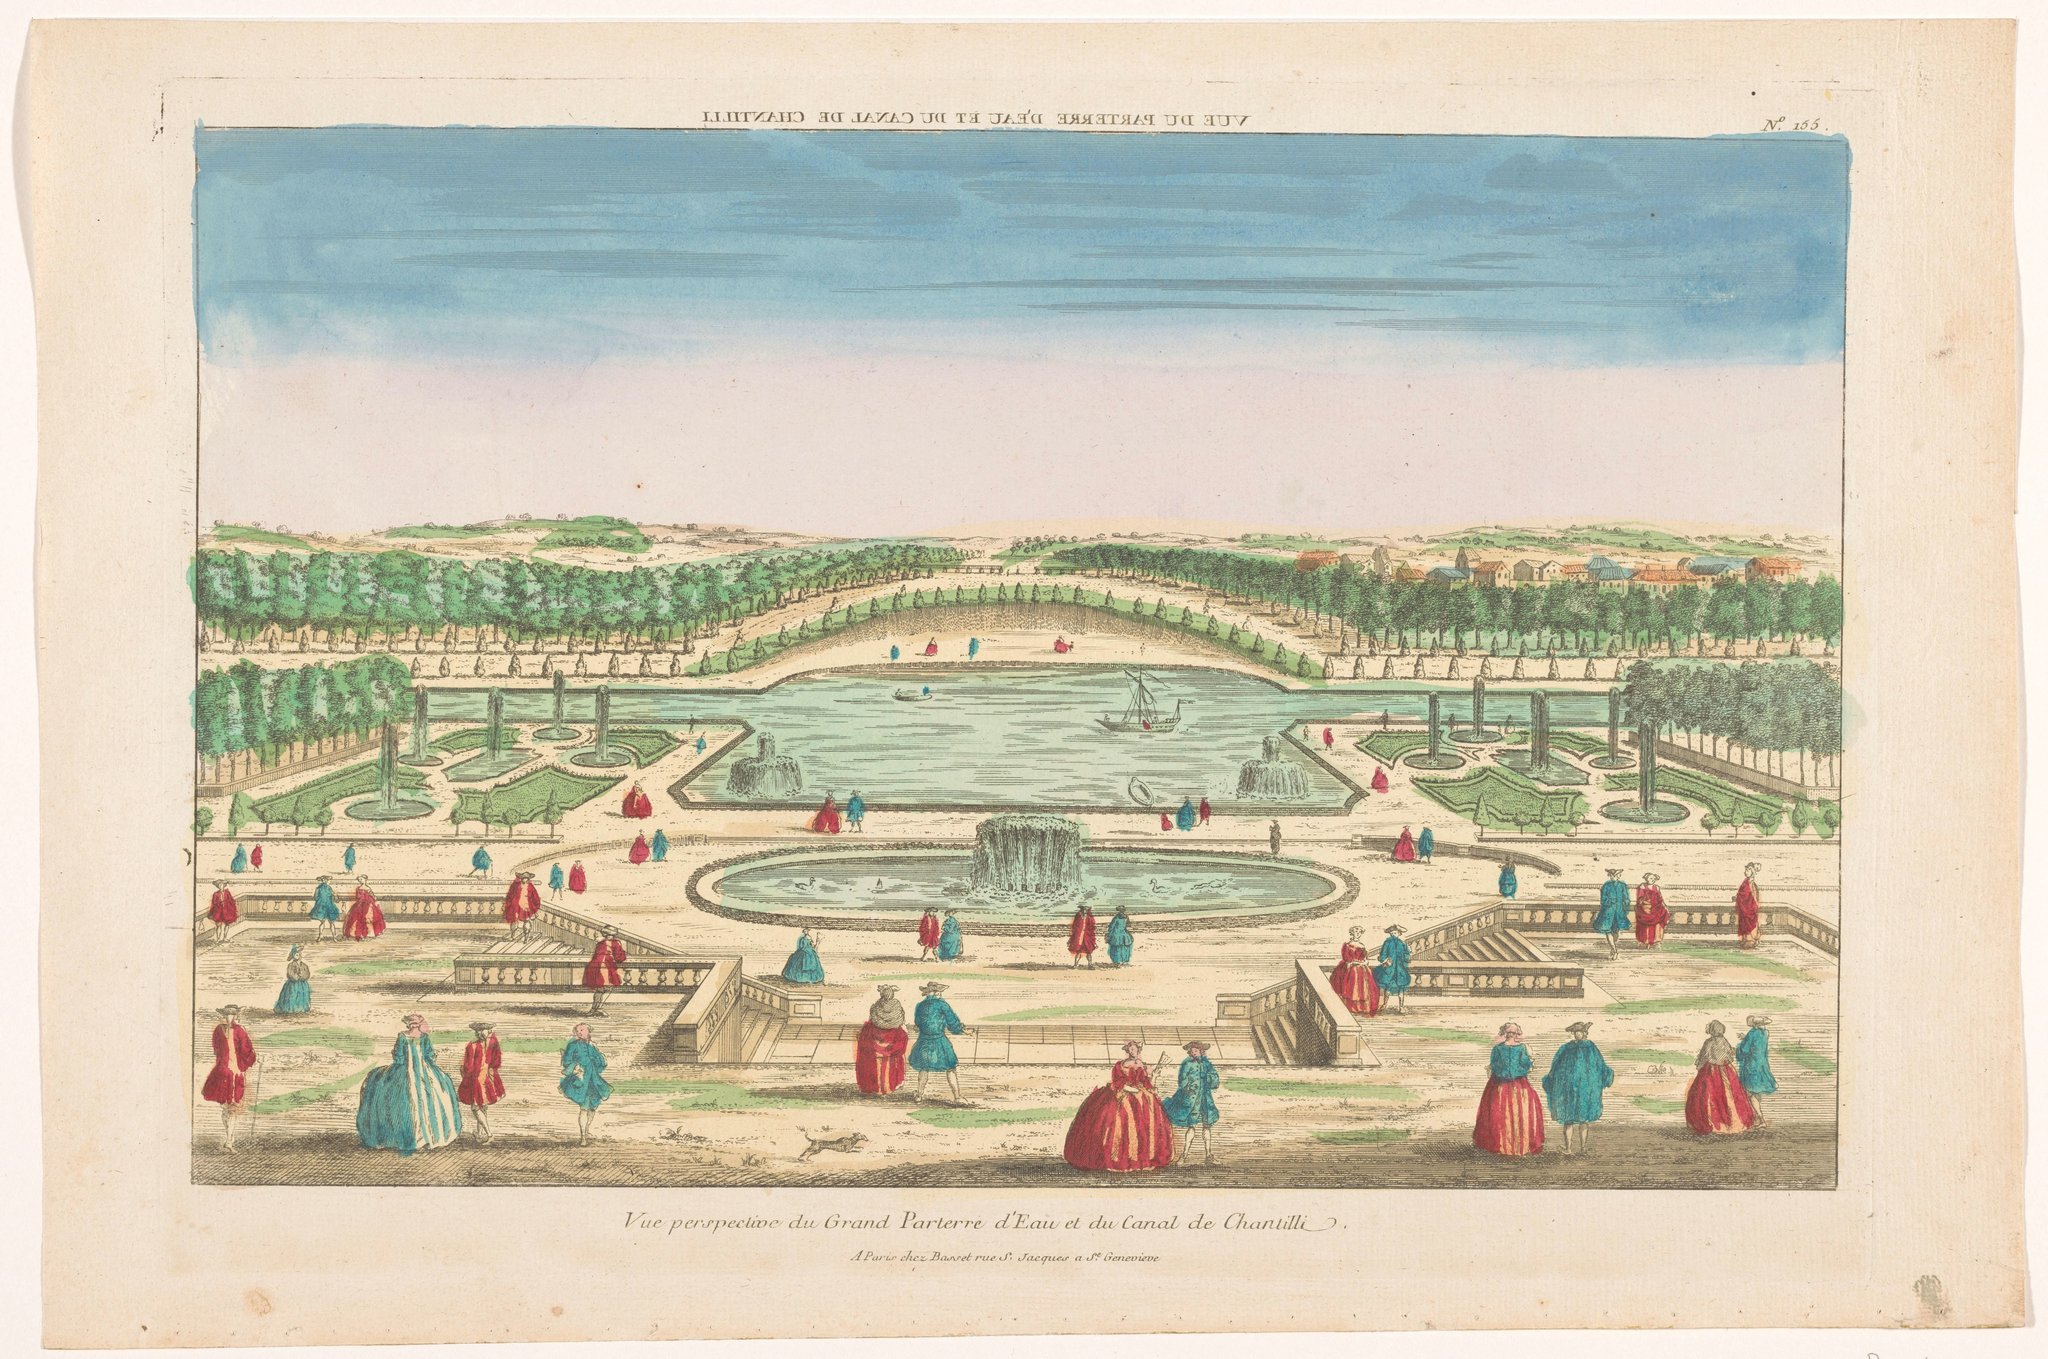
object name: print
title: Vue du parterre d'eau et du canal de Chantilli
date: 1700-1799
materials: paper, watercolor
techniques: brush, etching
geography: france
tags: flight of steps, garden, garden fountain, ornamental plants, water-works in garden, civic architecture; edifices; dwellings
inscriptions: watermark, collector's mark: Lugt 2166